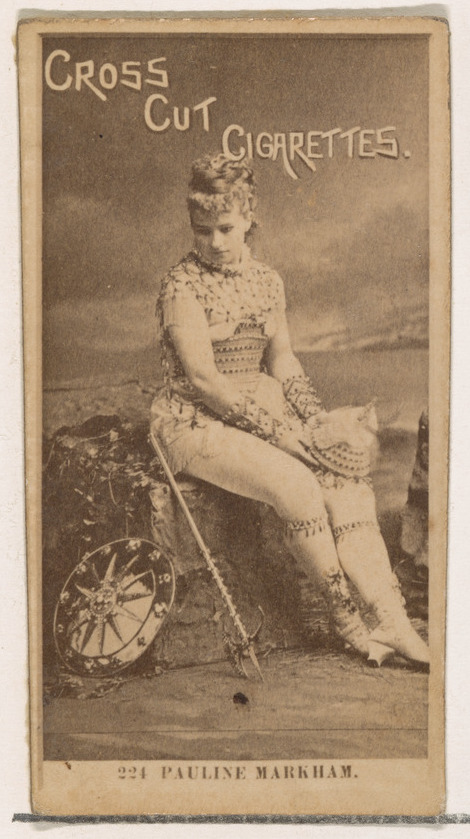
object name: print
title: Card Number 224, Pauline Markham, from the Actors and Actresses series (N145-2) issued by Duke Sons & Co. to promote Cross Cut Cigarettes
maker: w. duke, sons & co.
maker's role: publisher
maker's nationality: american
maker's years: 1870-1920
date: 1880-1889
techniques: albumen silver print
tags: portraits,women,actresses